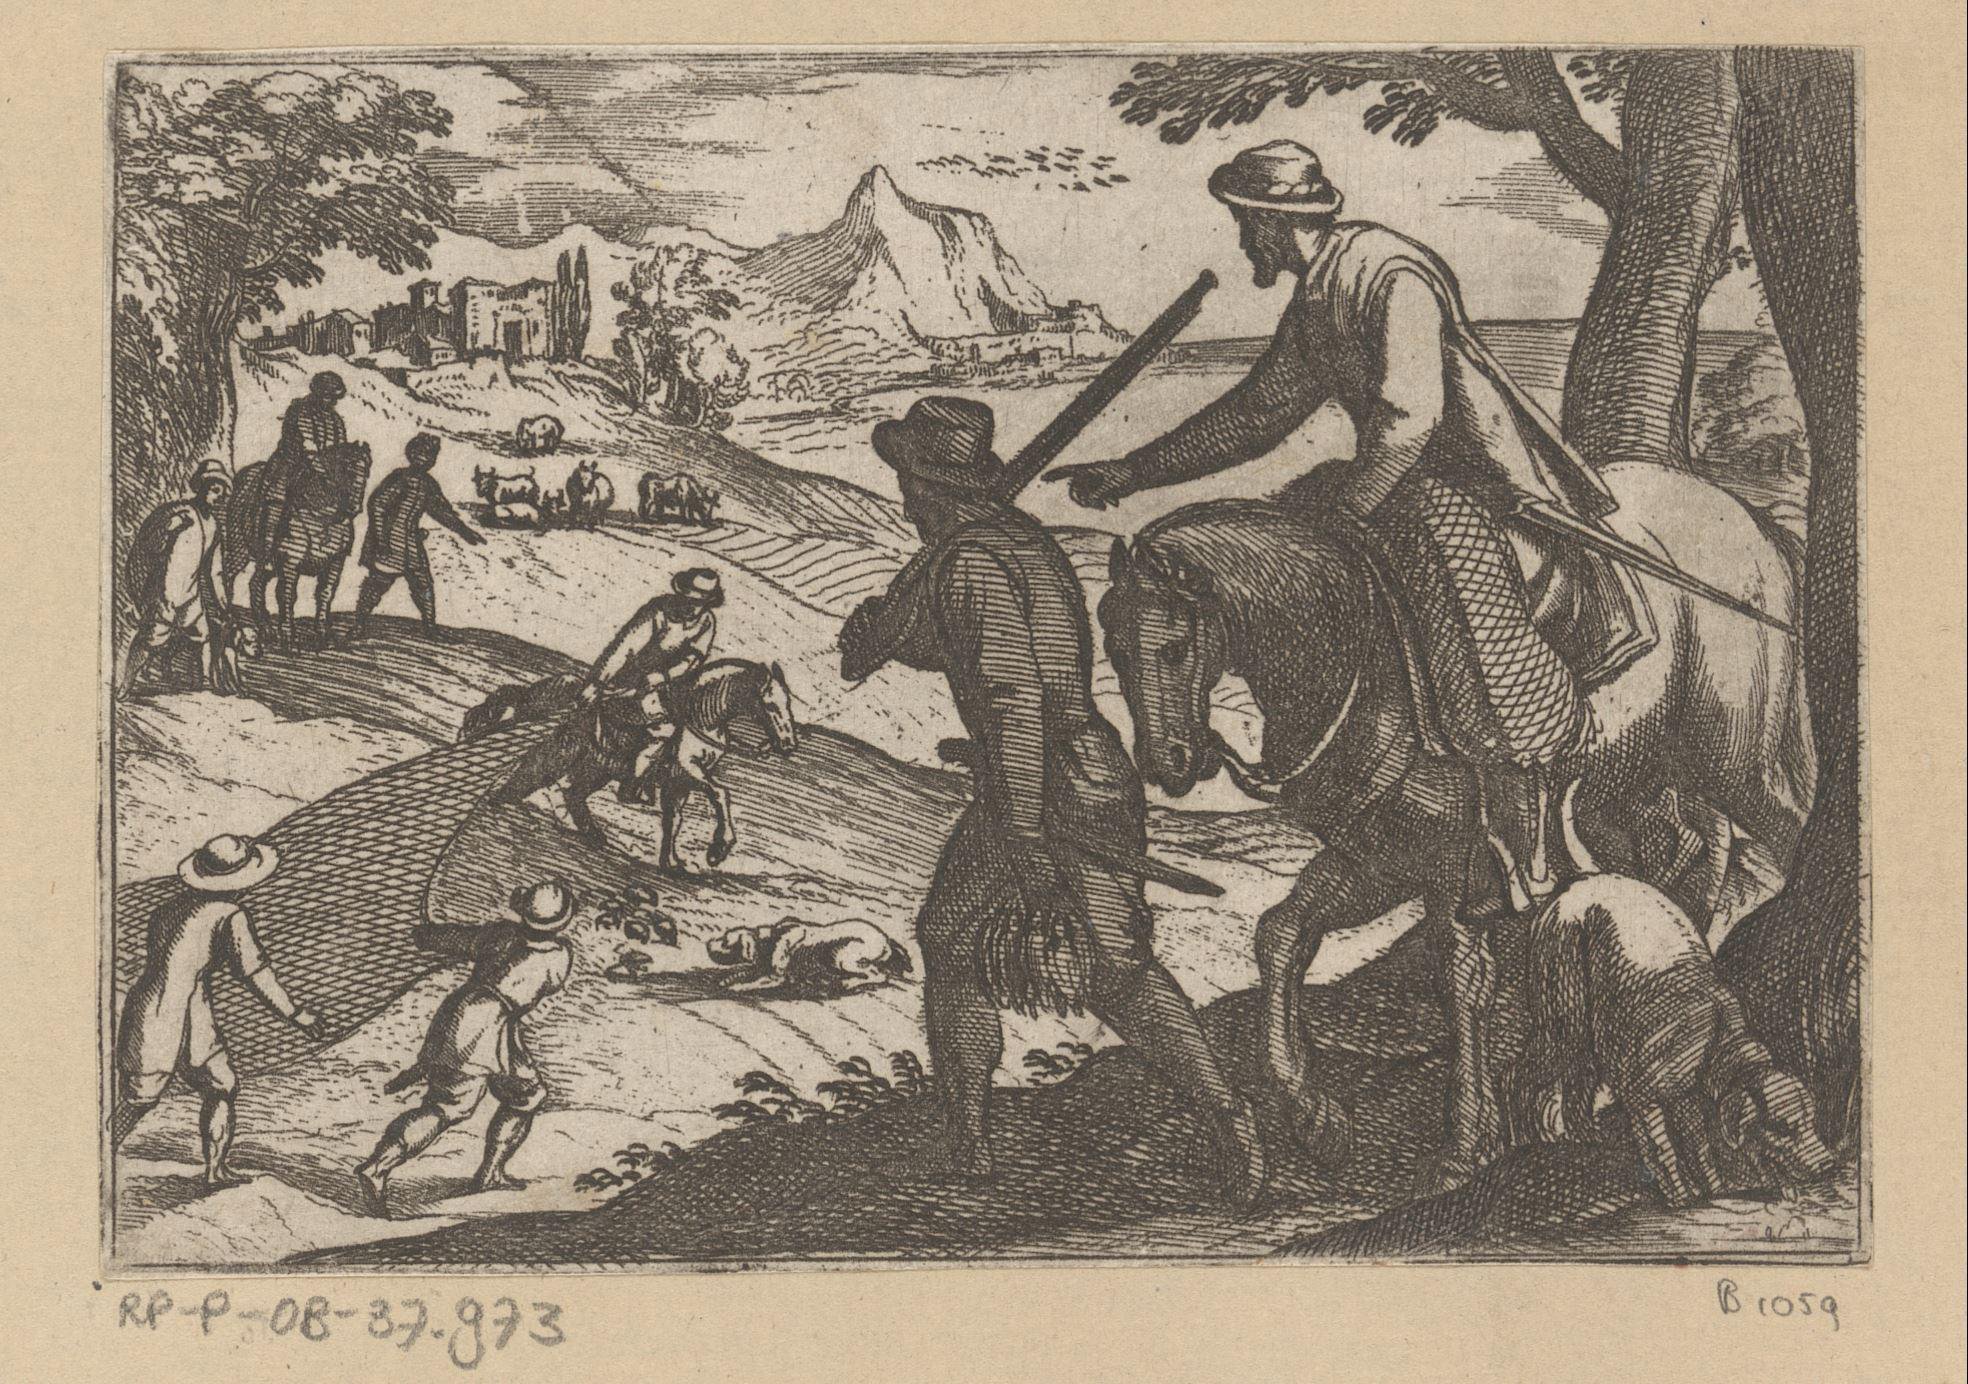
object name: print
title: Jagers vangen vogels met netten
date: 1598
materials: paper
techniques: etching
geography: vatican city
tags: hunter, hunters hunting (n.b.: in 1988-1990 this notation denoted the concept of 43c11421 'hunters resting during the hunt'), bird hunting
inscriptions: collector's mark: Lugt 240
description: Landschap met jagers die met behulp van een net en een jachthond vogels vangen. Op de voorgrond een jager te paard.